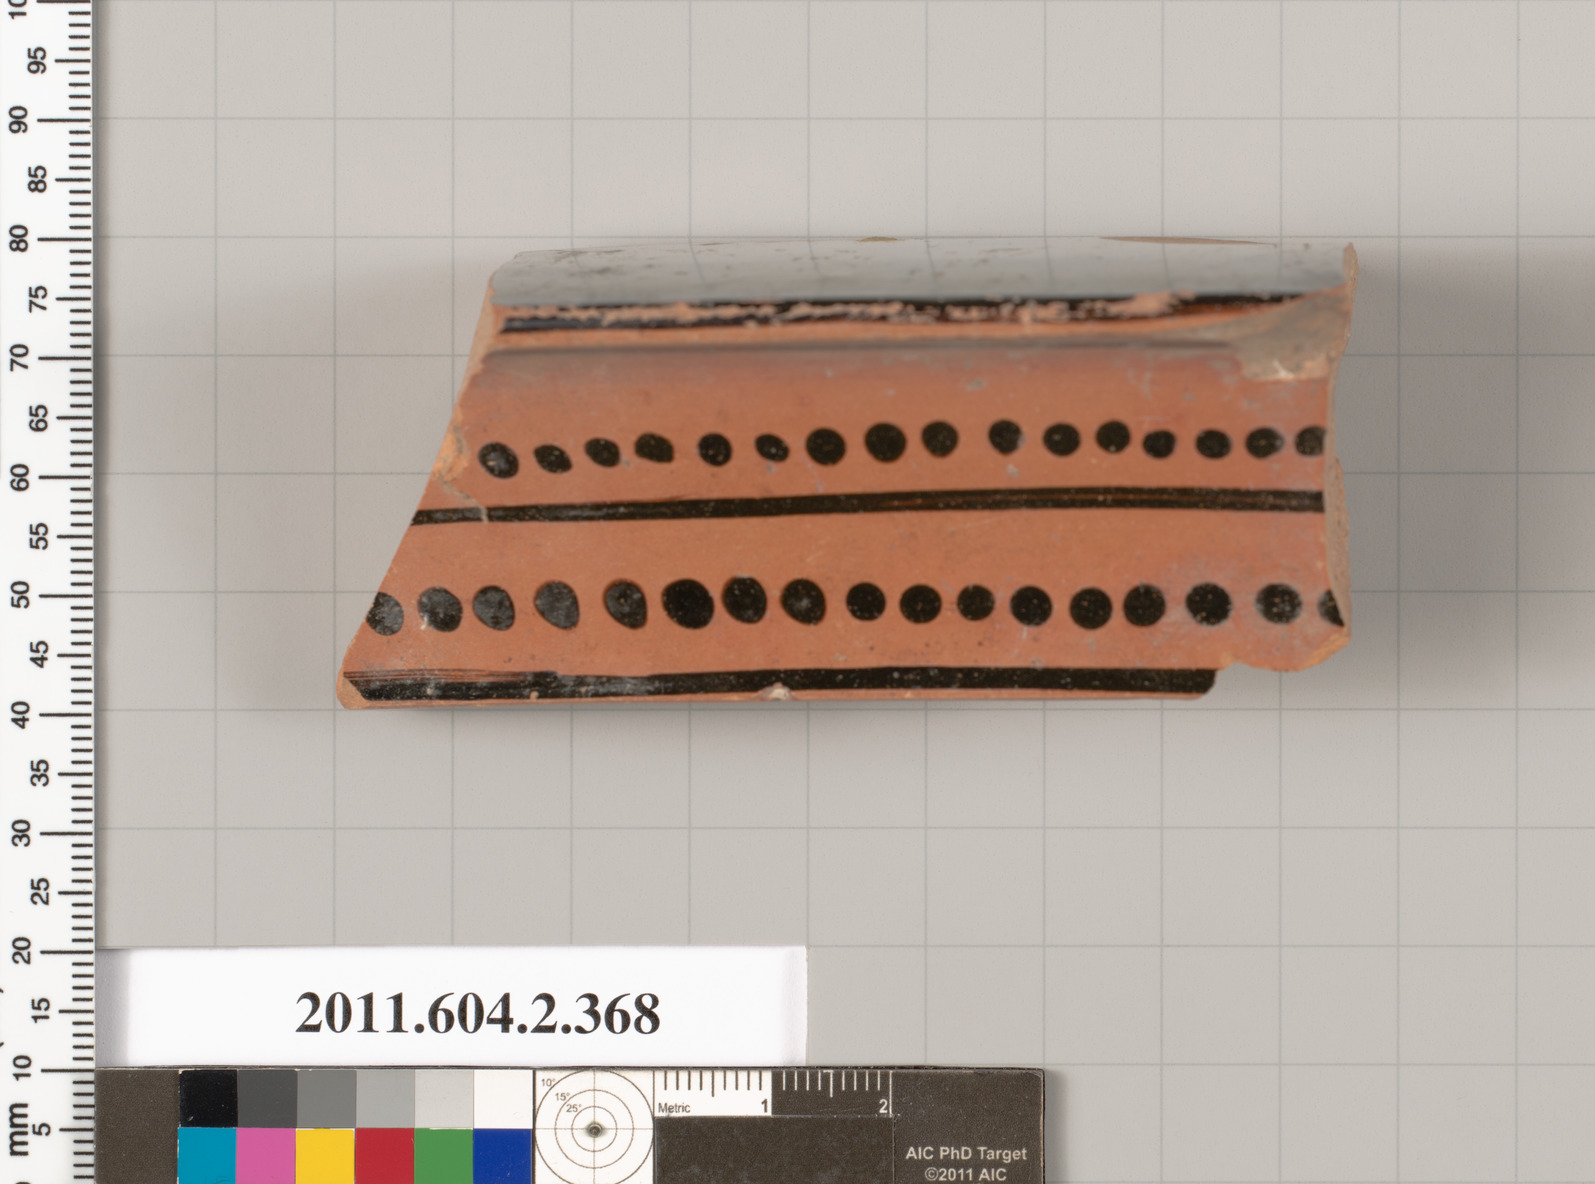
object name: column krater fragment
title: Terracotta fragment of a column-krater (bowl for mixing wine and water)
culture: greek, attic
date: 450-430 BCE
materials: terracotta